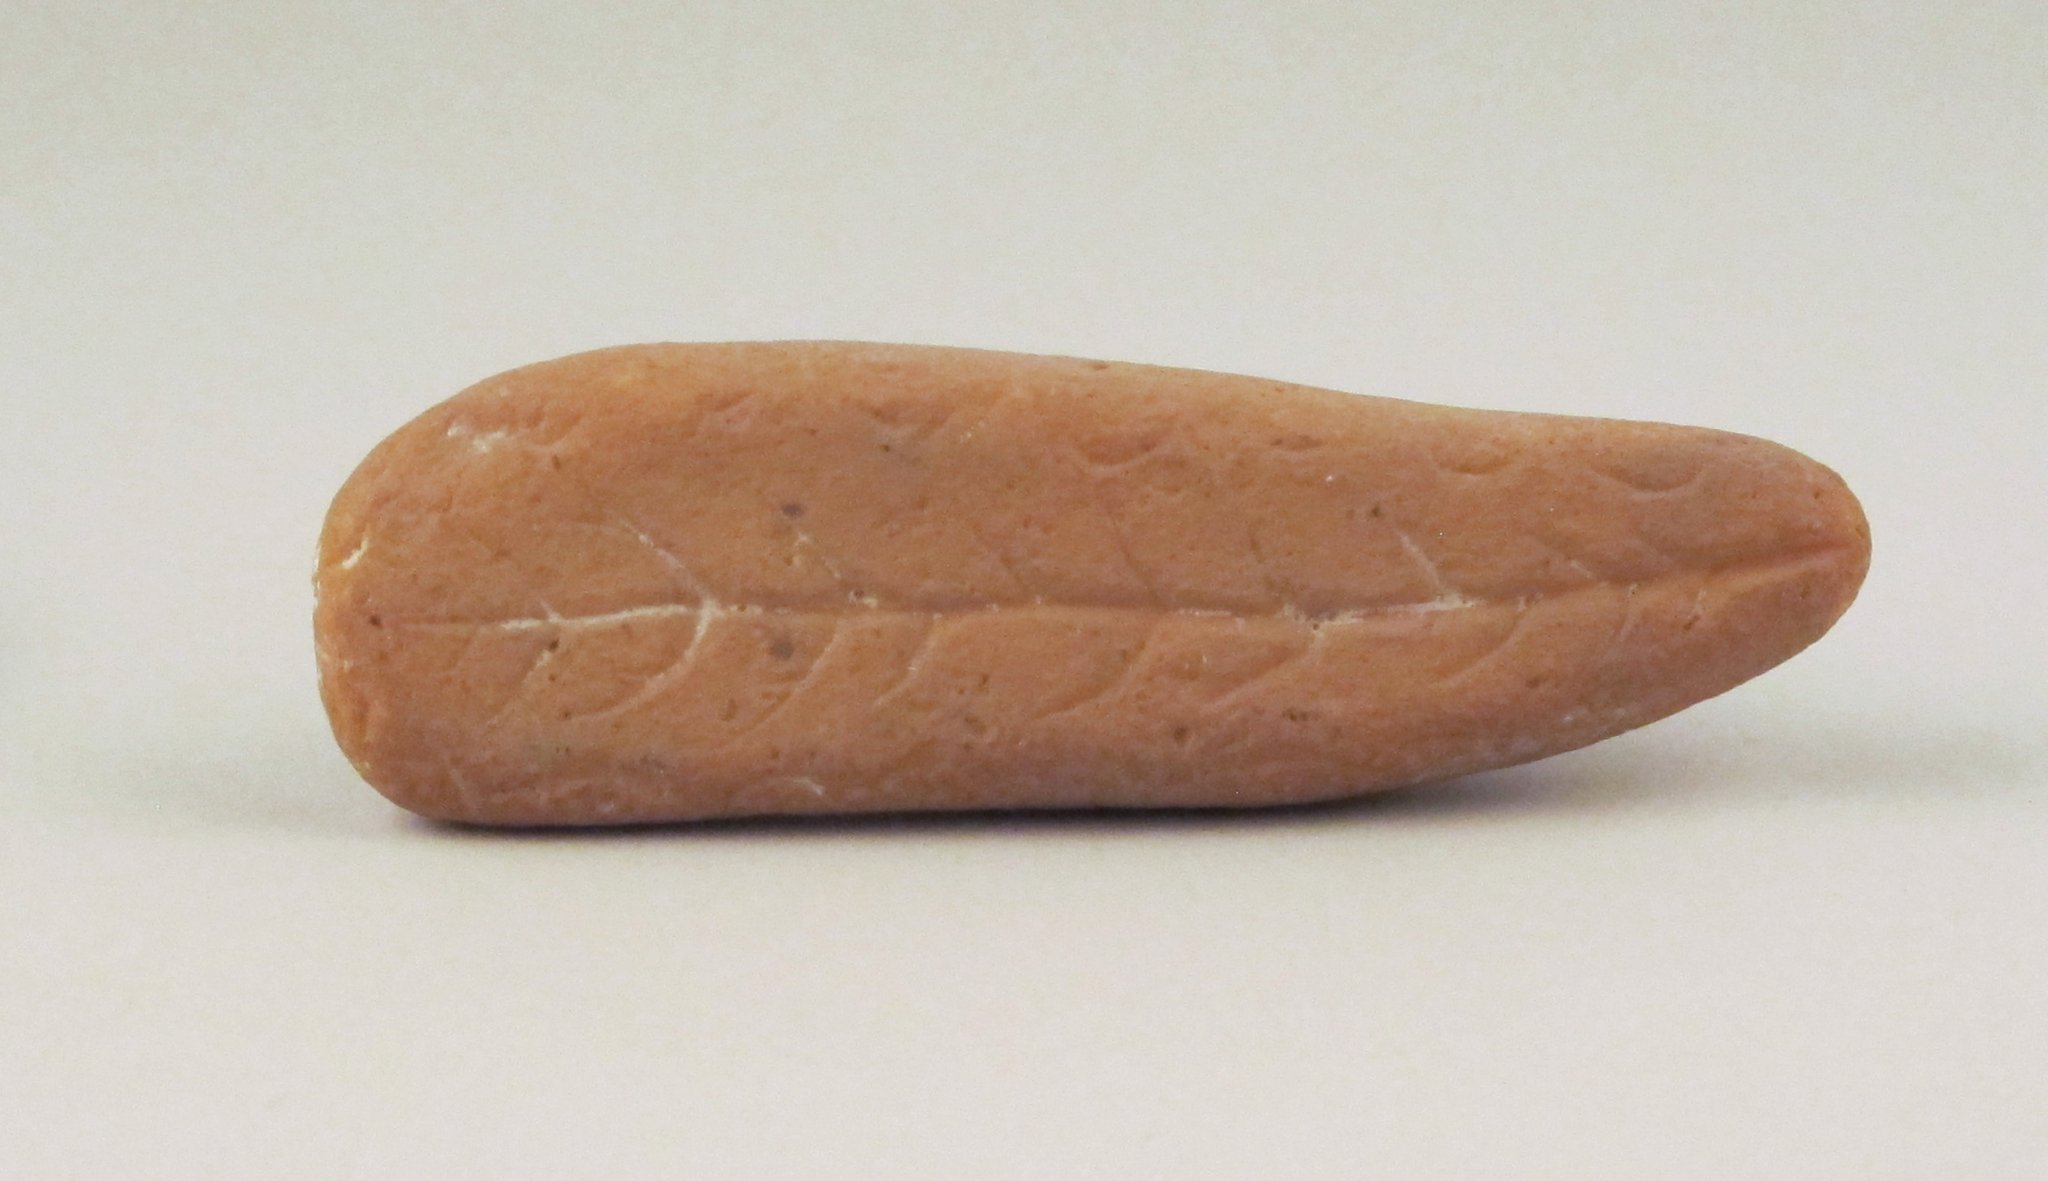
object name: potter's stamp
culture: roman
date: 670 BCE-330 CE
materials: terracotta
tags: leaves